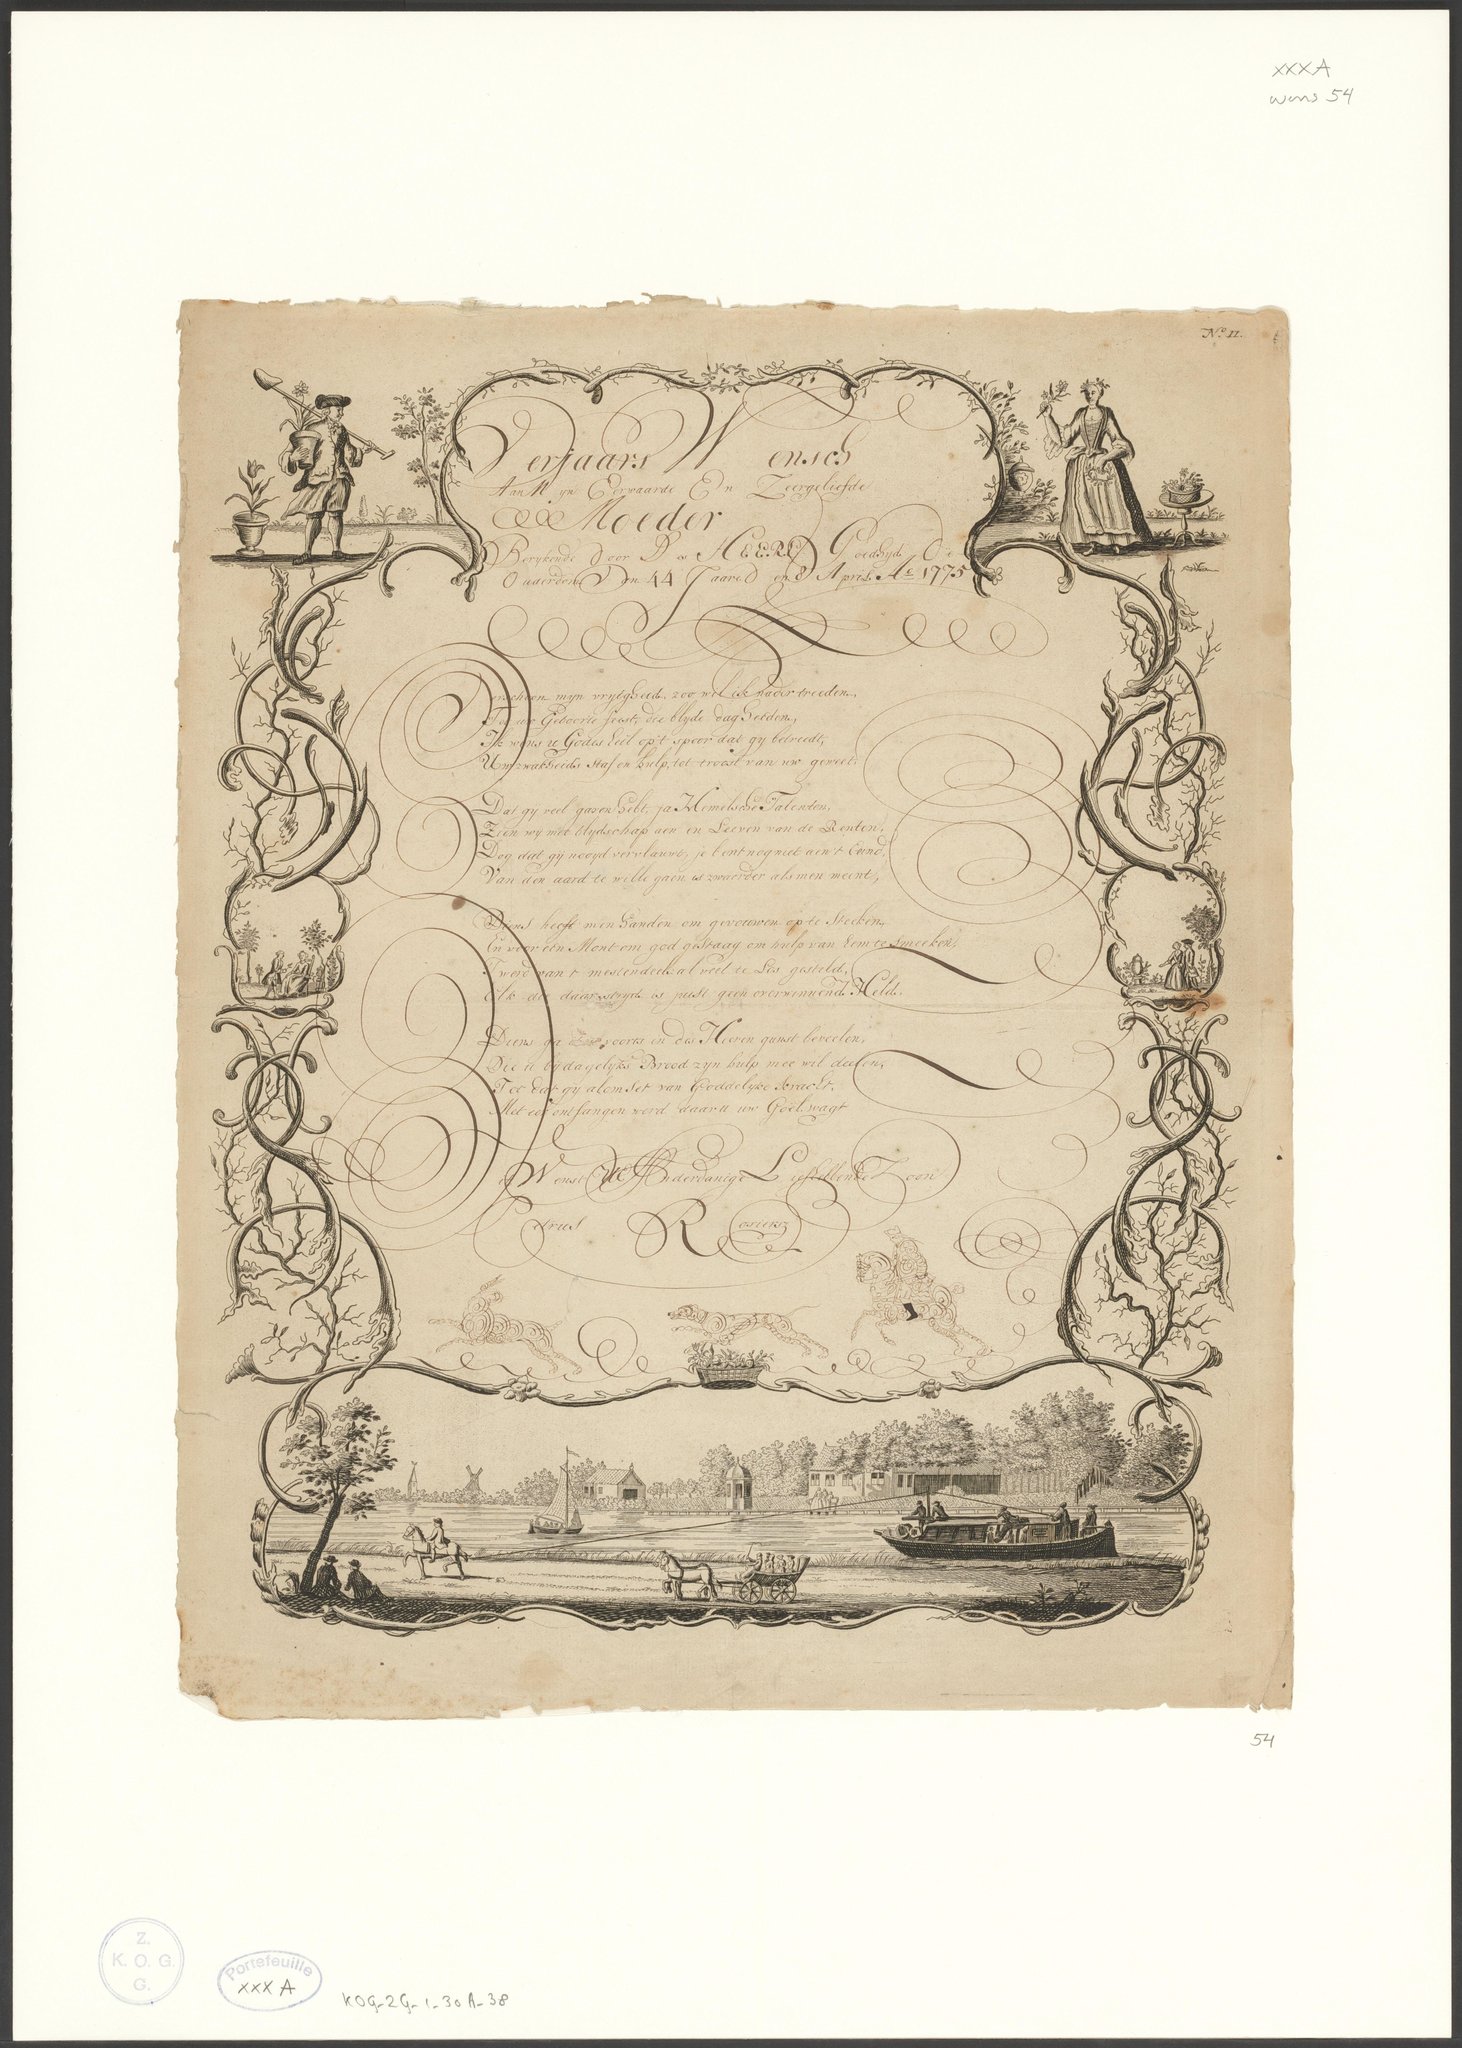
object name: wensbrief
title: Verjaardagswens door Petrus Rosiersz, 1775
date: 1805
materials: ink, paper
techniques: calligraphy, etching, handwriting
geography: amsterdam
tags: birthday, tow-boat, towing-barge, gardening, calligraphy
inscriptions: collector's mark, collector's mark: Lugt 1641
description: Verjaardagswens door Petrus Rosiersz. Gericht aan zijn moeder bij haar 44ste verjaardag op 8 april 1775. Vers geschreven op een voorgedrukt blad met een kader gevormd door ranken en wortels, tuinman, onderaan een trekschuit in een vaart. Met een gekalligrafeerde jachtscène. Genummerd rechtsboven: No. 11. Onderwerpsrubrieken binnen de Atlas Zeden en Gewoonten: Nieuwjaars- en kermiswenschen.